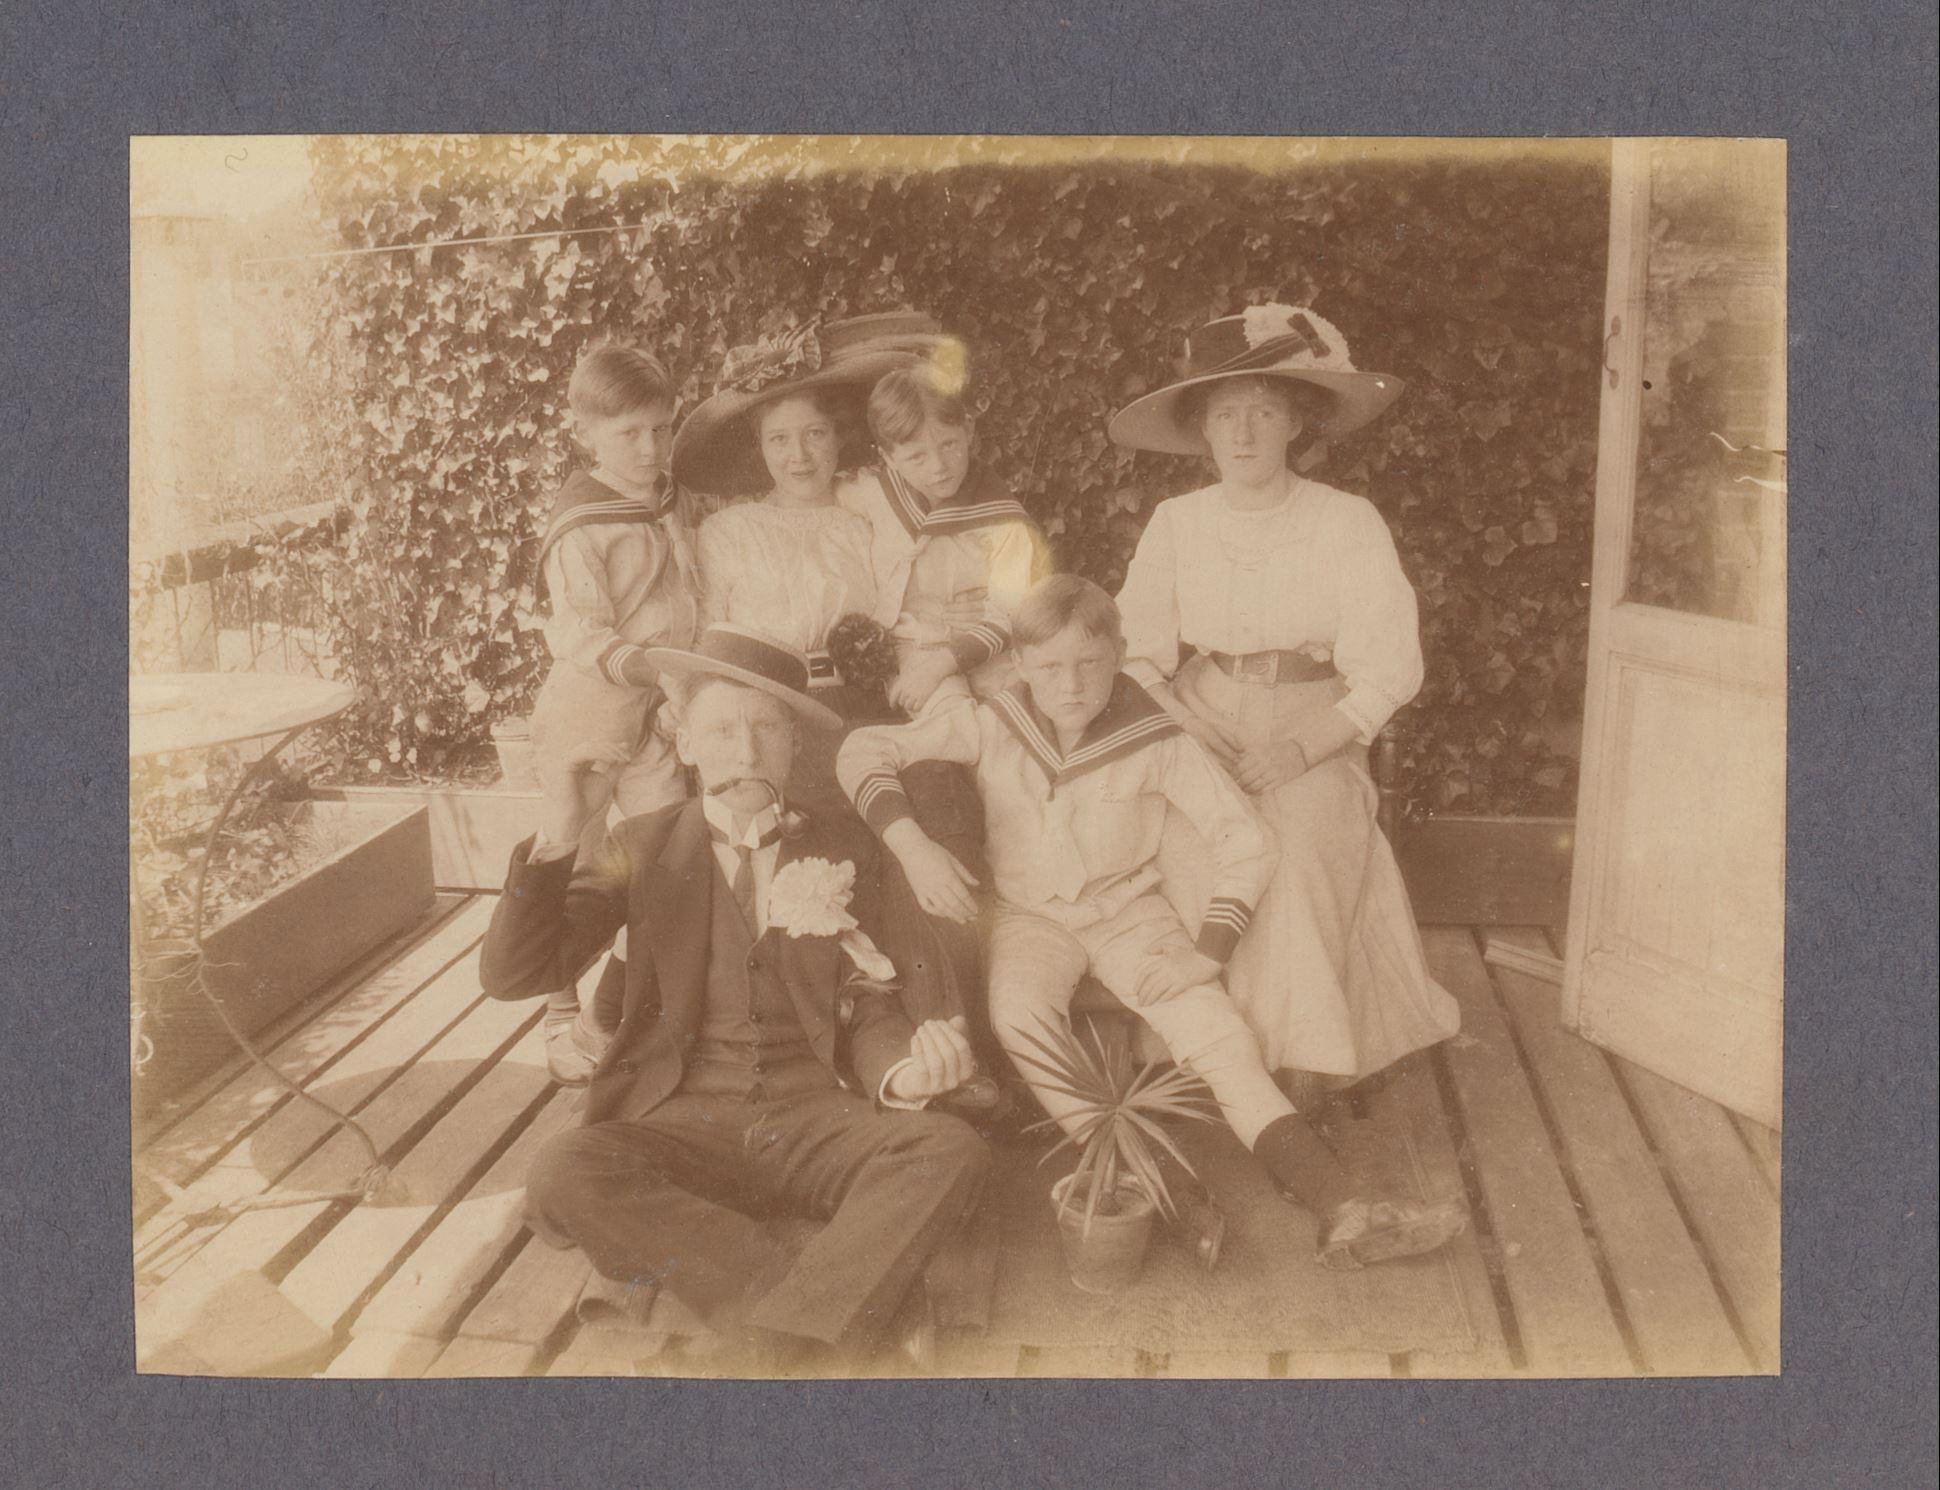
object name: album leaf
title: Groepsportret van David, Greet, Gerard, Gerrit en Johan Vermeulen met een vrouw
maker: cornelis johannes lodewicus vermeulen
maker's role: fotograaf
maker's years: 1861-1936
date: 1910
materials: photographic support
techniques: gelatin silver print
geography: the hague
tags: adult woman, adult man, child, family life